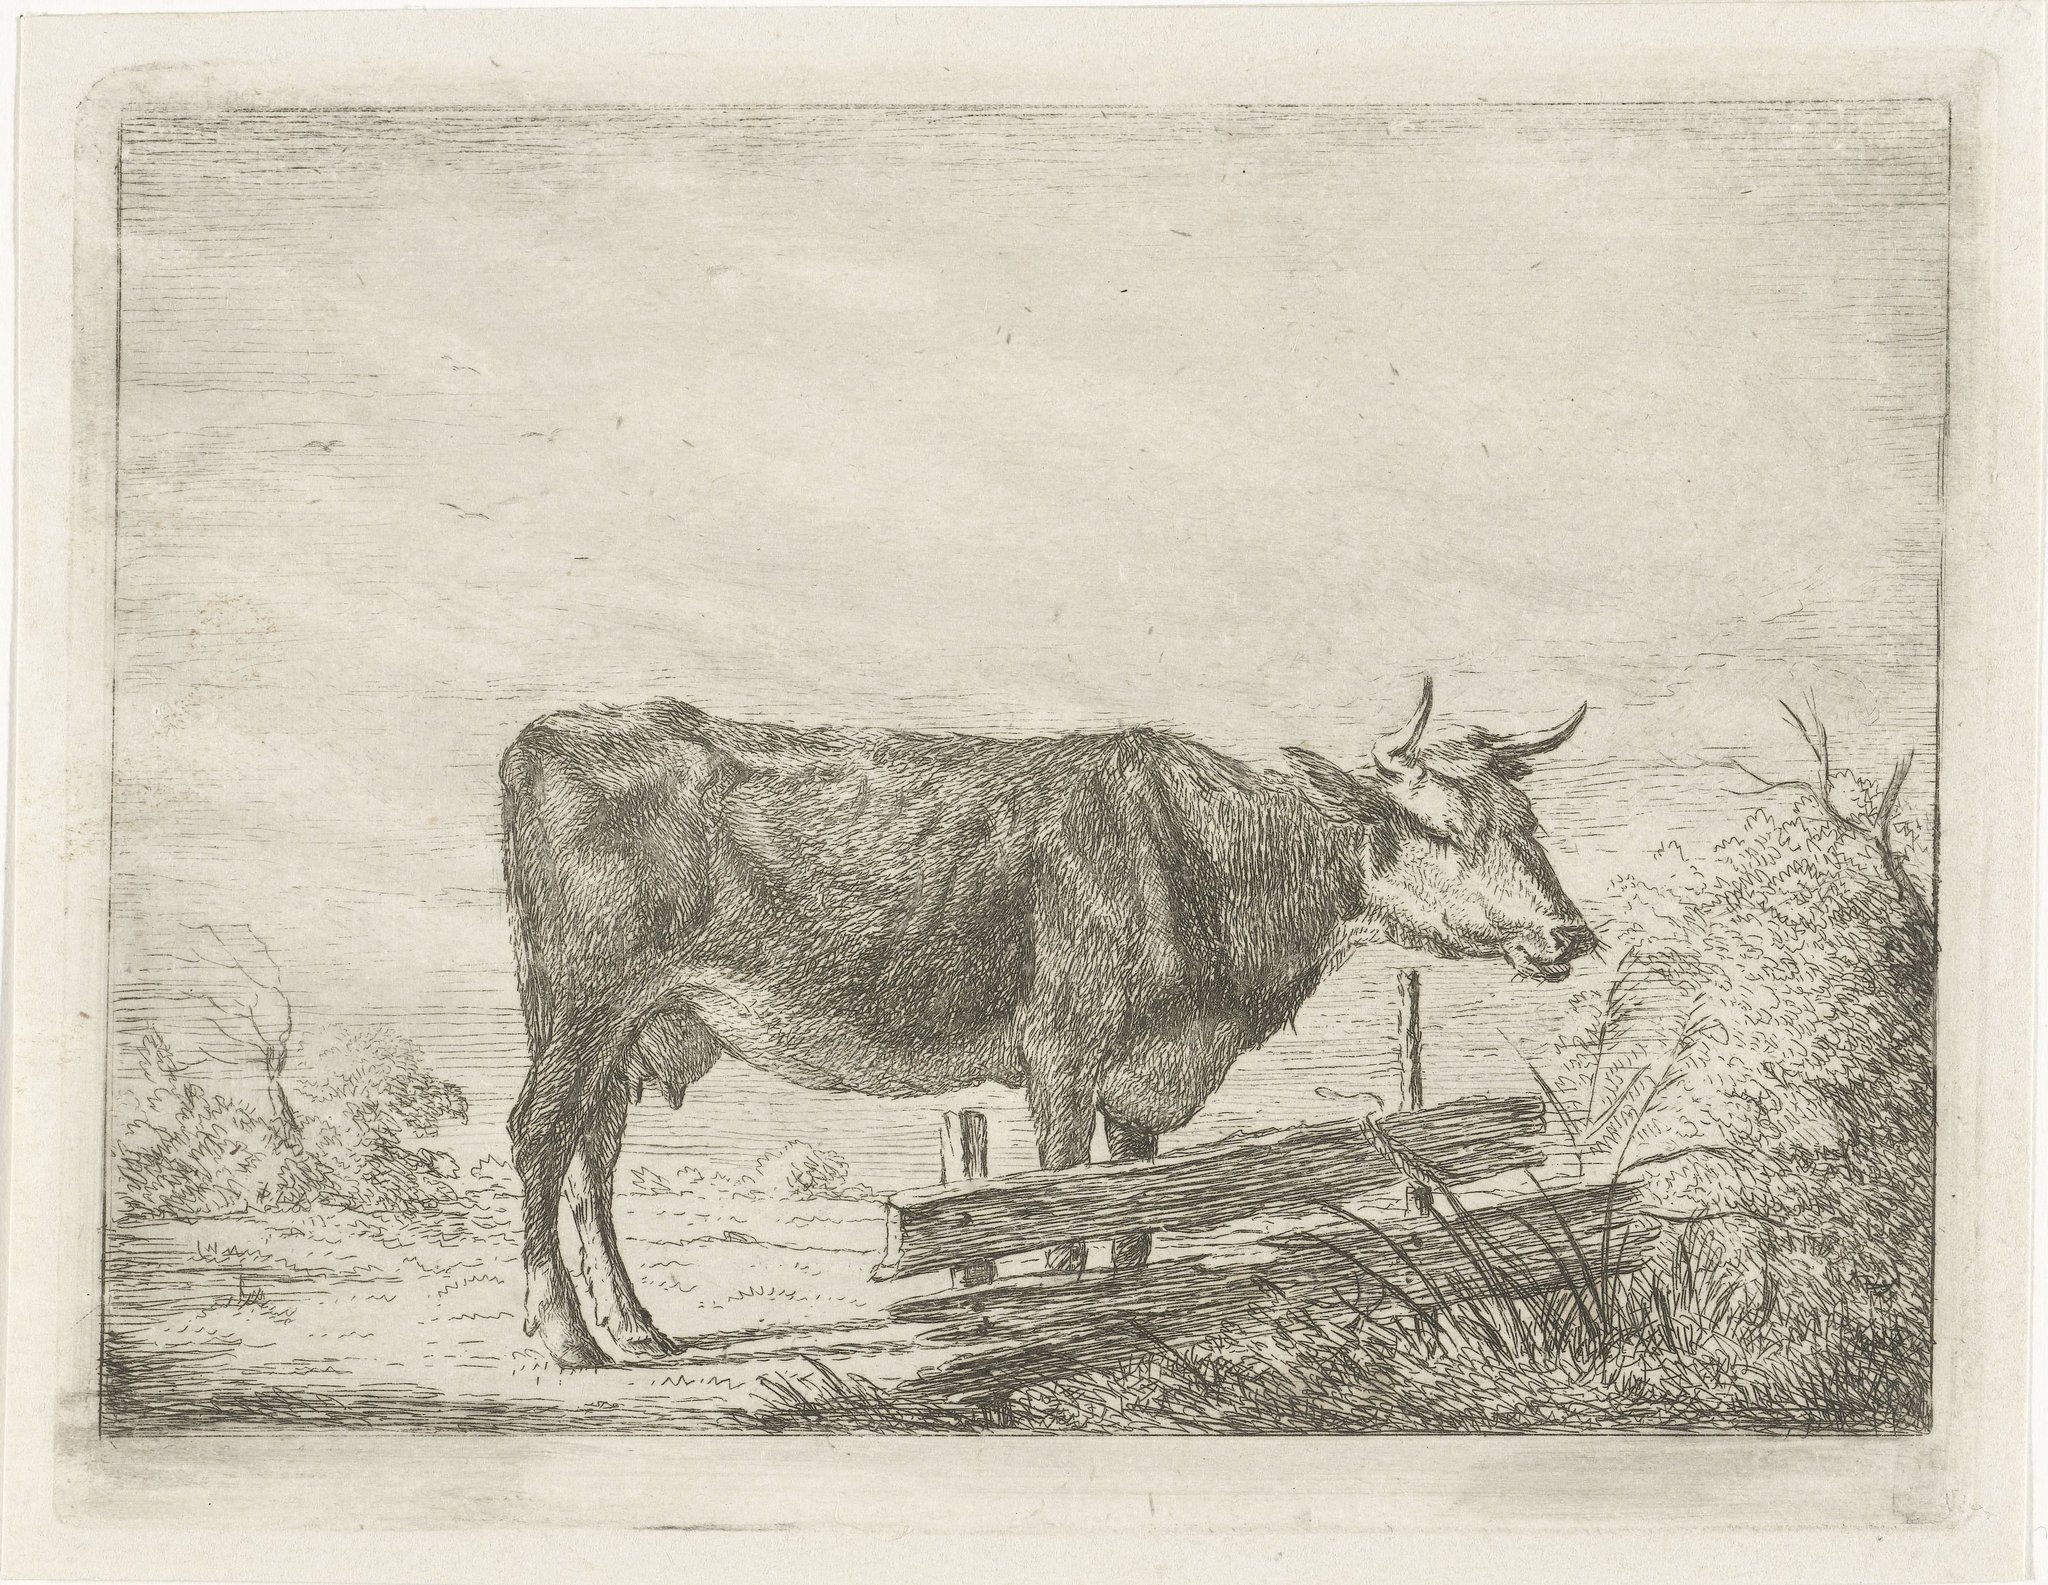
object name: print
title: Koe, staand bij een hek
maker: jacobus cornelis gaal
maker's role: print maker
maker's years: 1796-1866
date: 1850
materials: paper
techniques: etching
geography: the hague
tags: cow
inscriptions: collector's mark: Lugt 2228